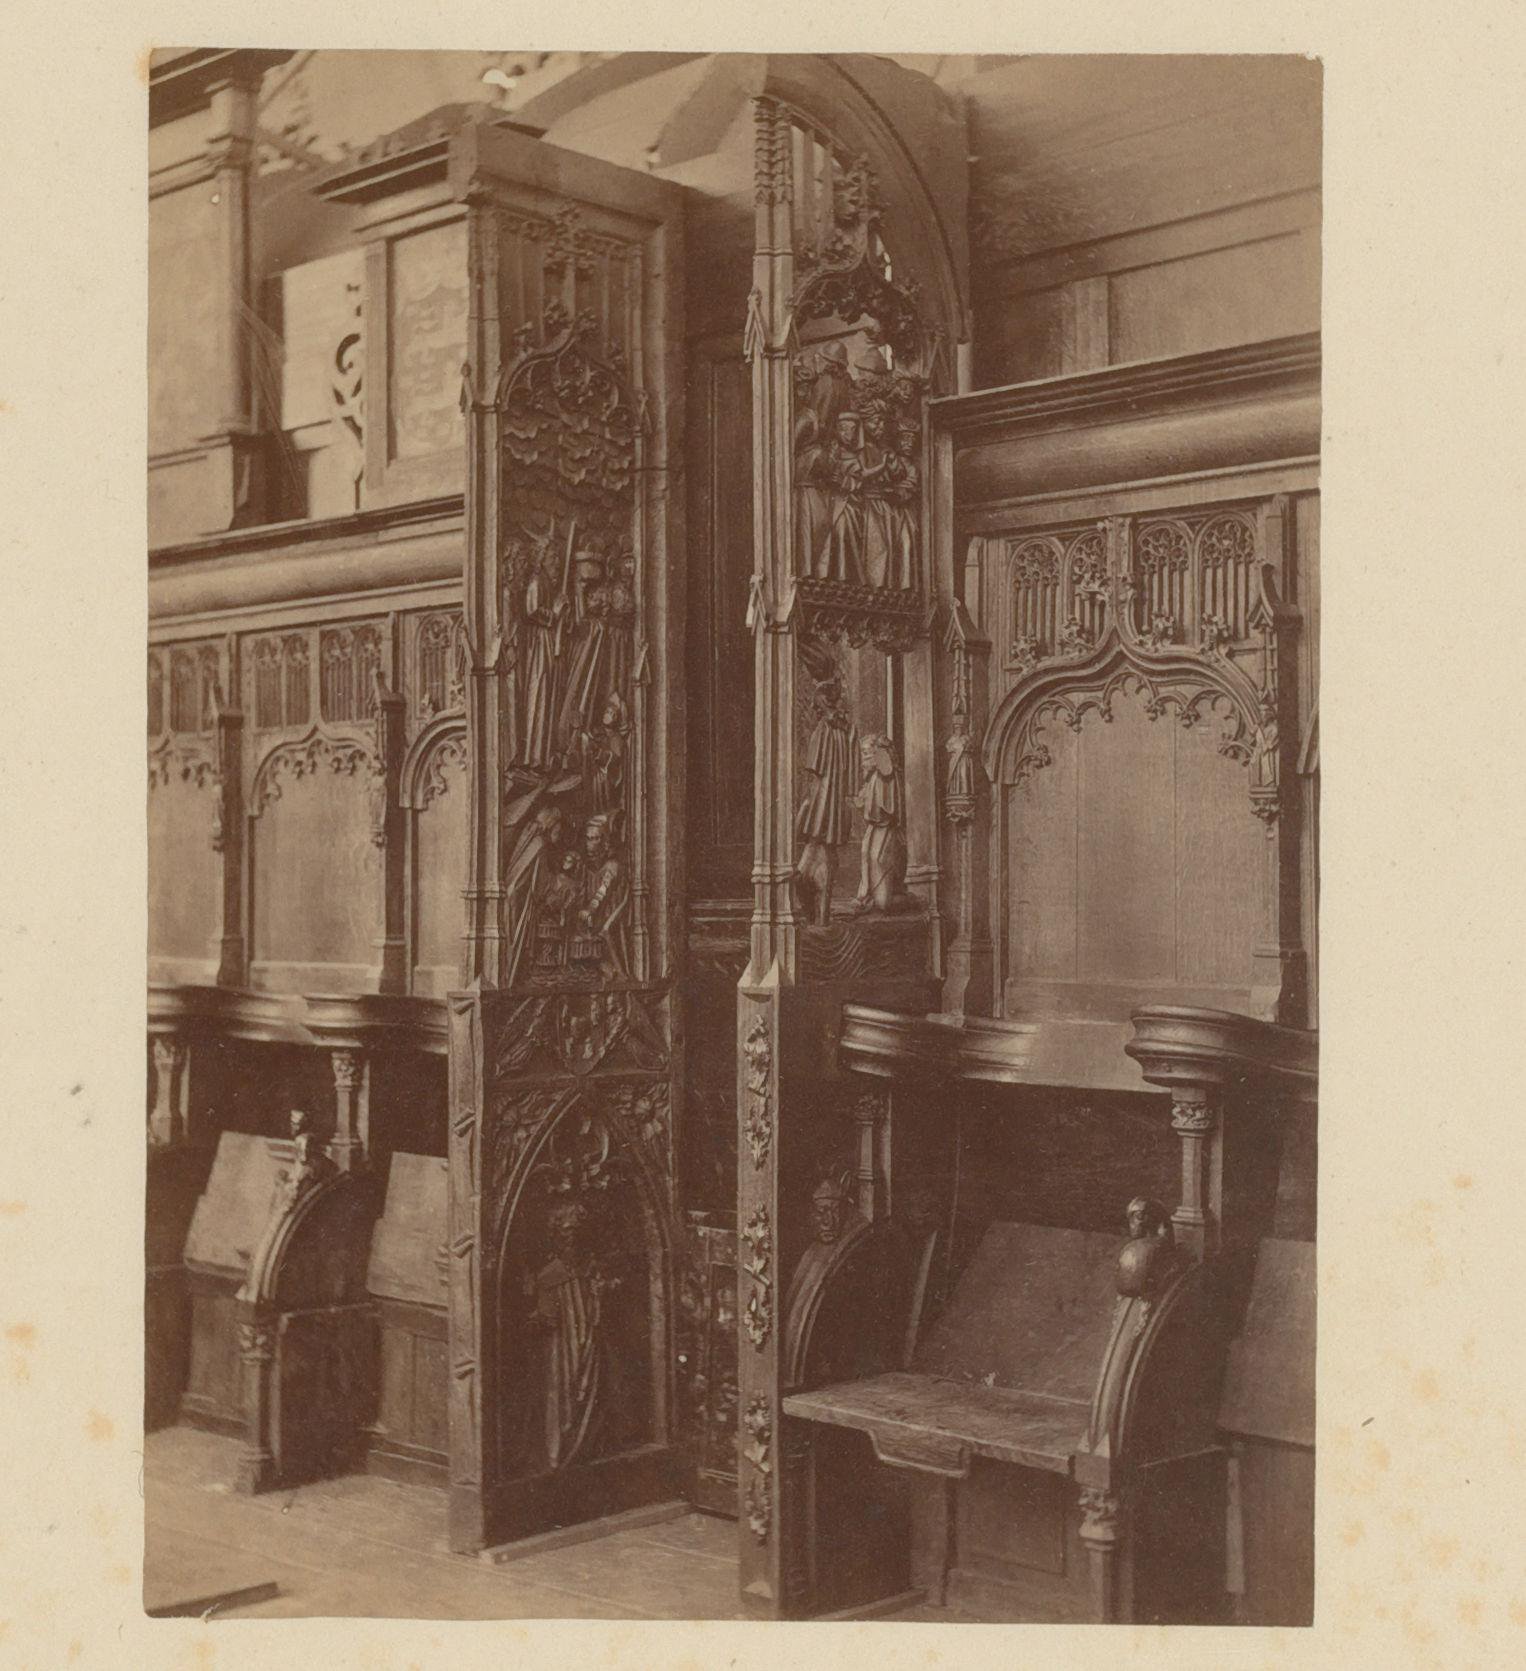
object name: photograph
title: Foto's van houtsnijwerk in de Martinikerk te Bolsward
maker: g.m. märckelbach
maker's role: publisher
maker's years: 1853-1904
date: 1879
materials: photographic support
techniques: albumen print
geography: bolsward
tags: carving ~ applied arts, piece of sculpture, reproduction of a piece of sculpture, wood carver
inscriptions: collector's mark, collector's mark: Lugt 1641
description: In een advertentie wordt de fotoserie aangeboden: HH. Liefhebbers van Antiquiteiten. GOTHIEKE BANKEN uit de XVe Eeuw. St. MARTINIKERK.--BOLSWARD. 8 Photographieën à f 4.50. ANTIEKE PREEKSTOEL, uit het midden der XVIIe EEUW. 4 Photographieën à f 2.25. Uitgave van: GEBRs. CORDES, Photografen [and] G.M. MÄRCKELBACH, Boek- en Kunsthandel, BOLSWARD. (Het nieuws van den dag: kleine courant, 12-07-1879.)